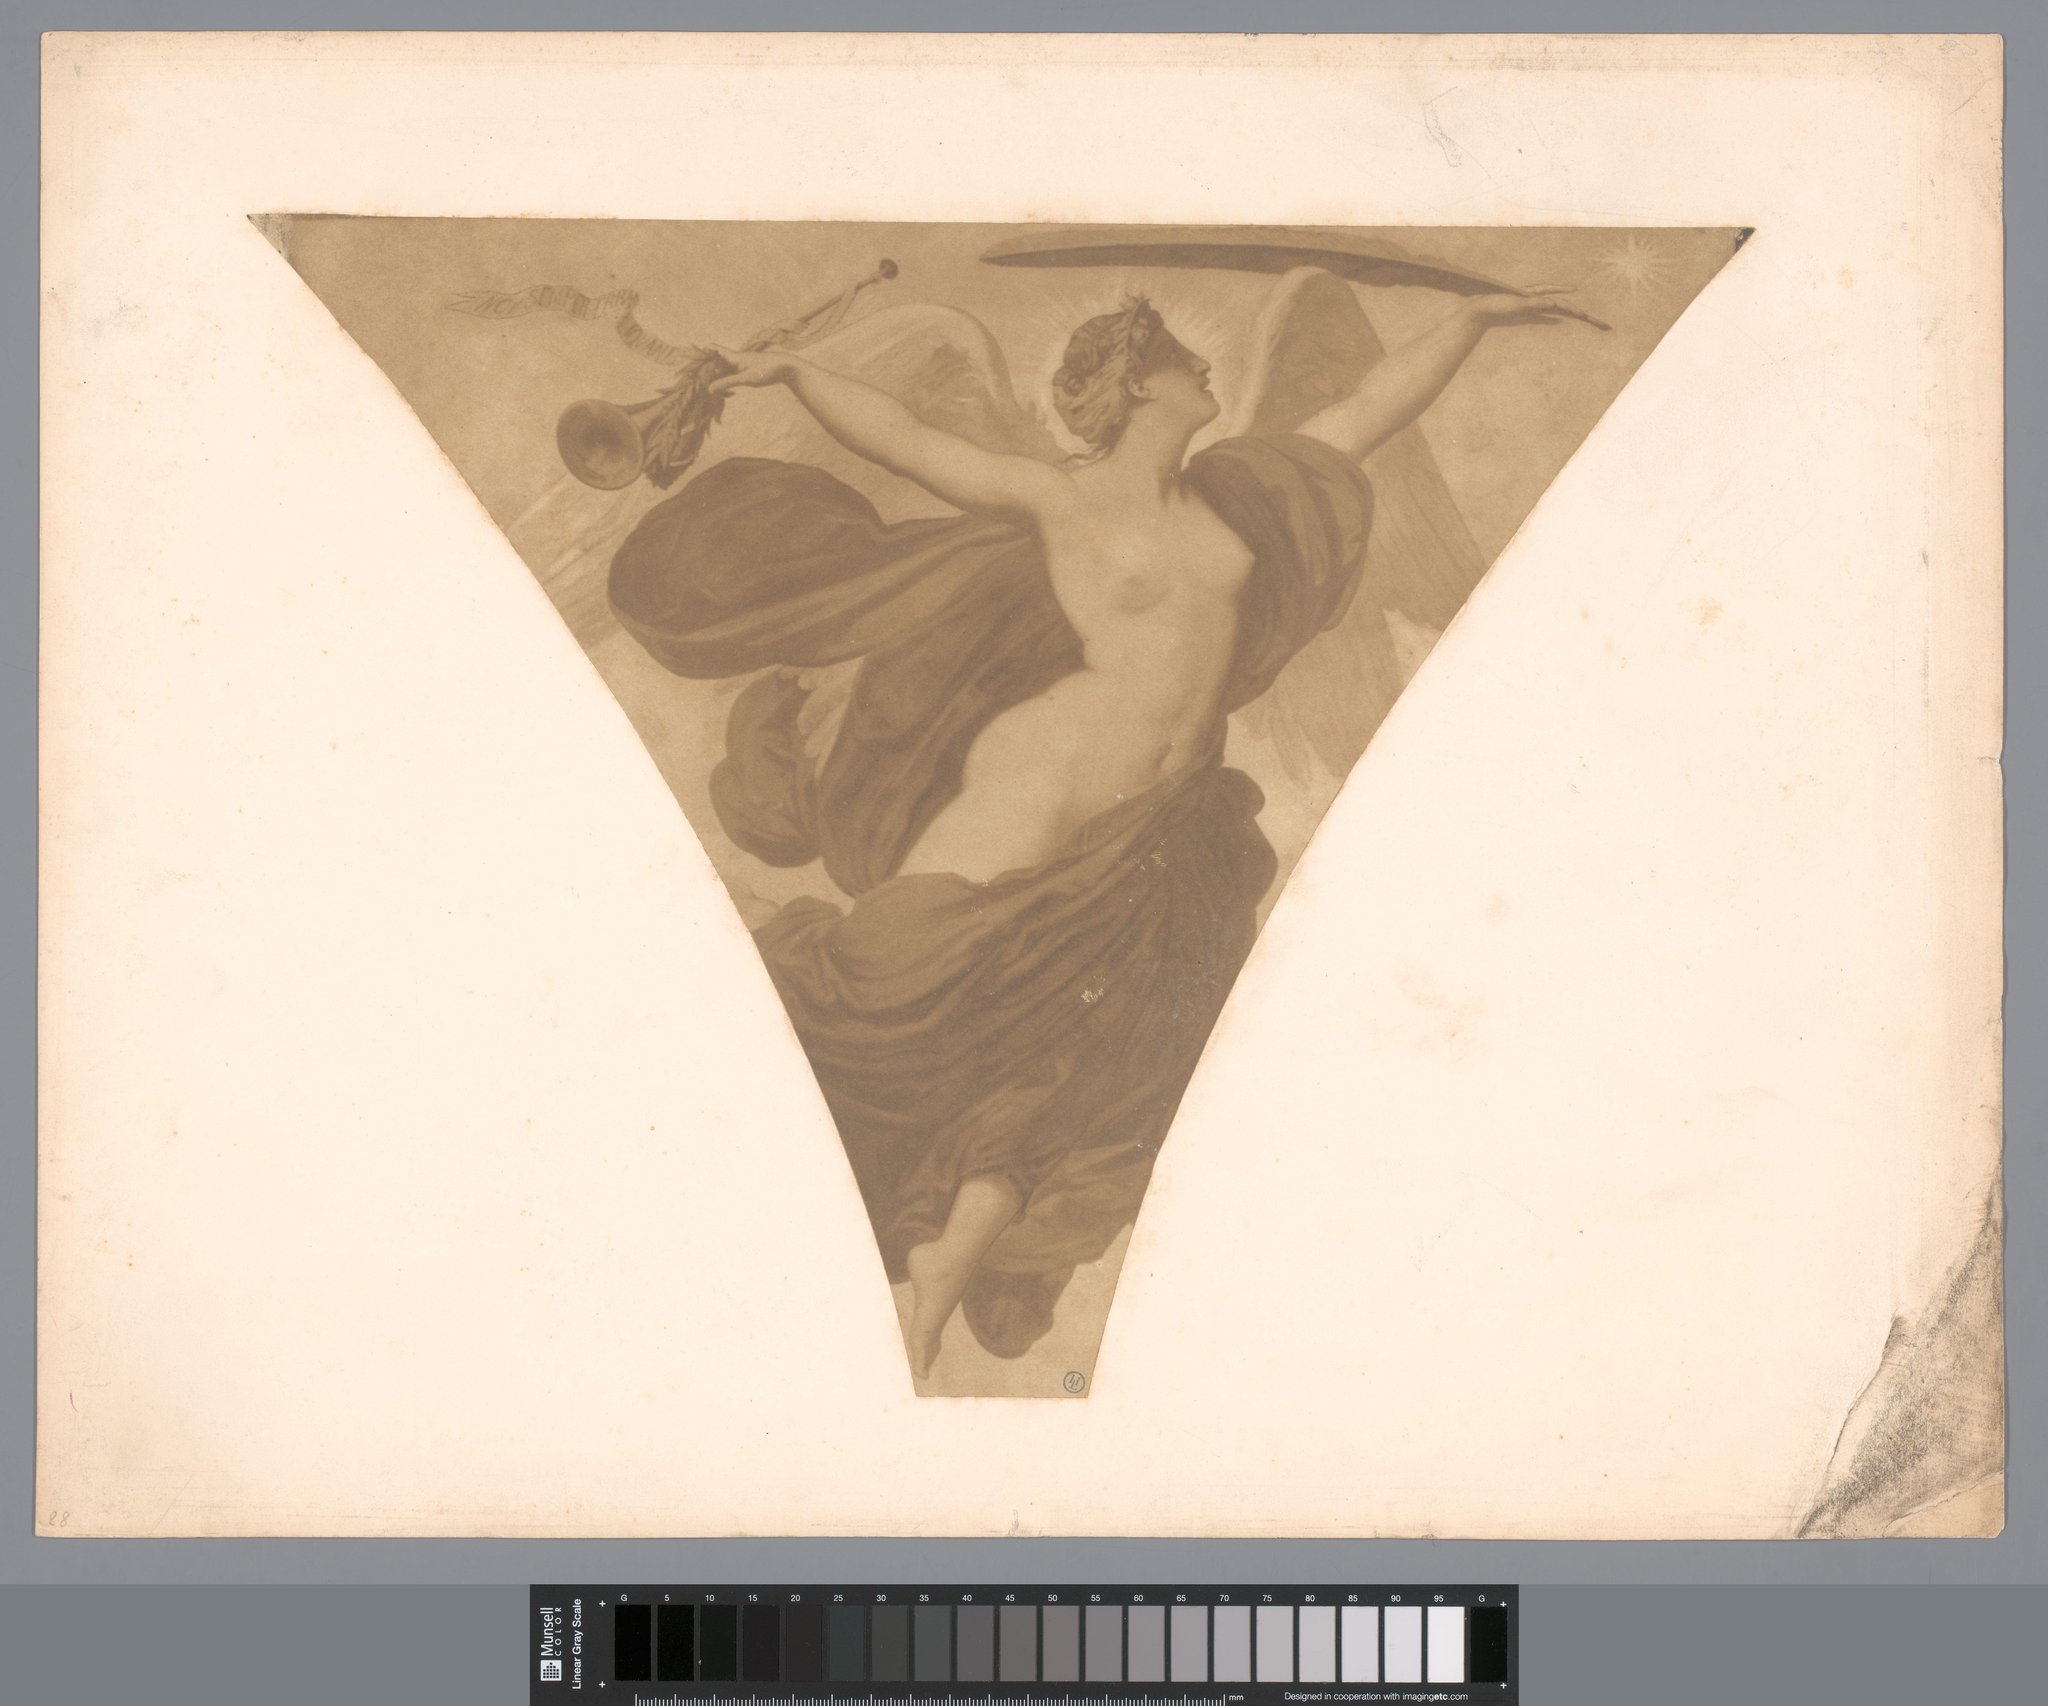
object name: photograph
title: Fotografische reproductie van decoratie aan plafond, Hotel de Ville, Parijs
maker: gustave le gray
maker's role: fotograaf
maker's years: 1820-1884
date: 1852-1853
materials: cardboard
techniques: salted paper print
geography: paris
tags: paris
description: Maakt onderdeel uit van een serie van 18 bladen met foto's van de cartons voor de plafondschilderingen door Henri Lehmann voor de Galerie des Fêtes in het Hotel de Ville, Parijs.